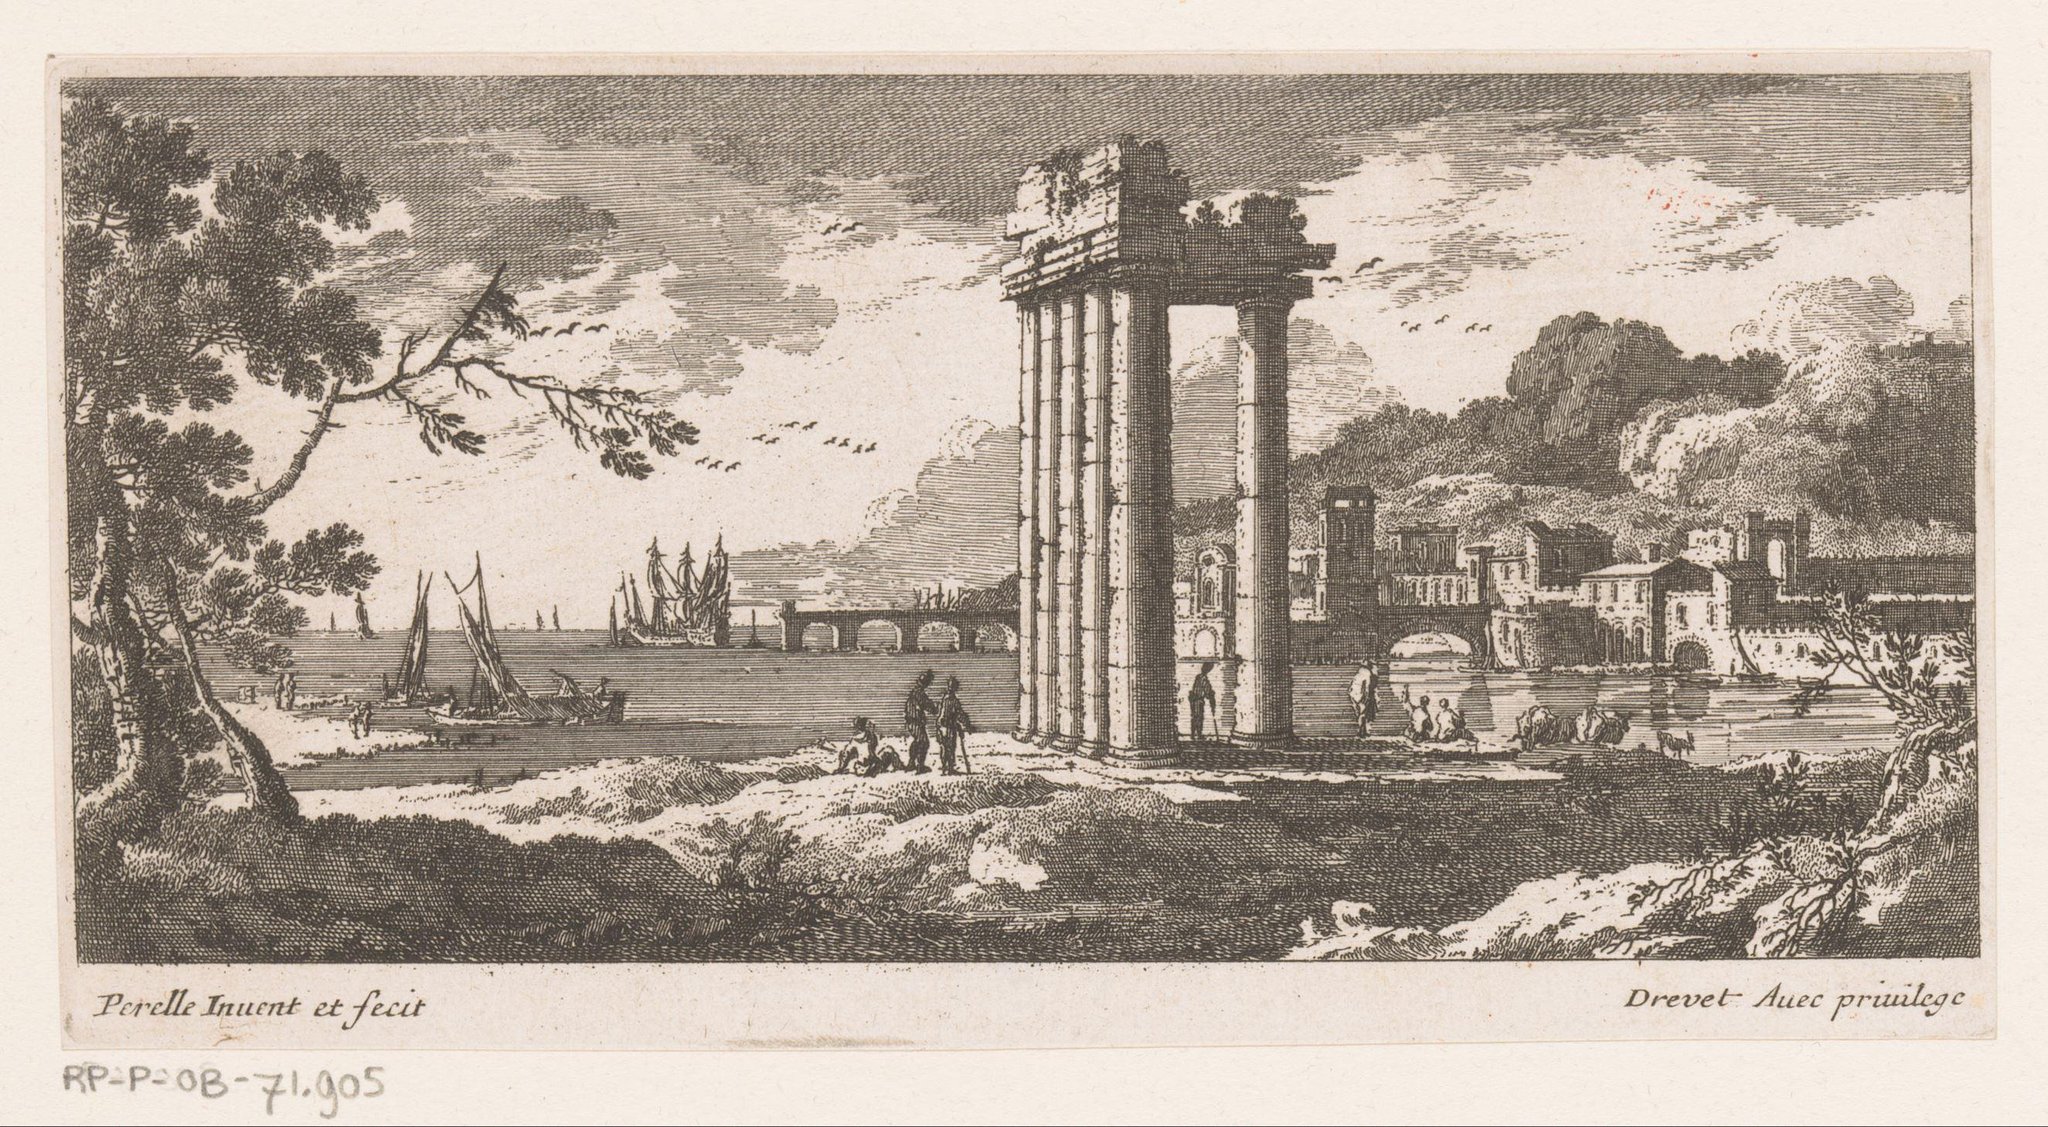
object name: print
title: Overblijfsel van tempel aan zee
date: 1673-1695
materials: paper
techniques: etching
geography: france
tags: landscape with ruins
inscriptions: collector's mark: Lugt 240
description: Prenten met het signatuur 'Perelle' kunnen zowel door vader Gabriel als door zonen Nicolas en Adam gemaakt zijn.